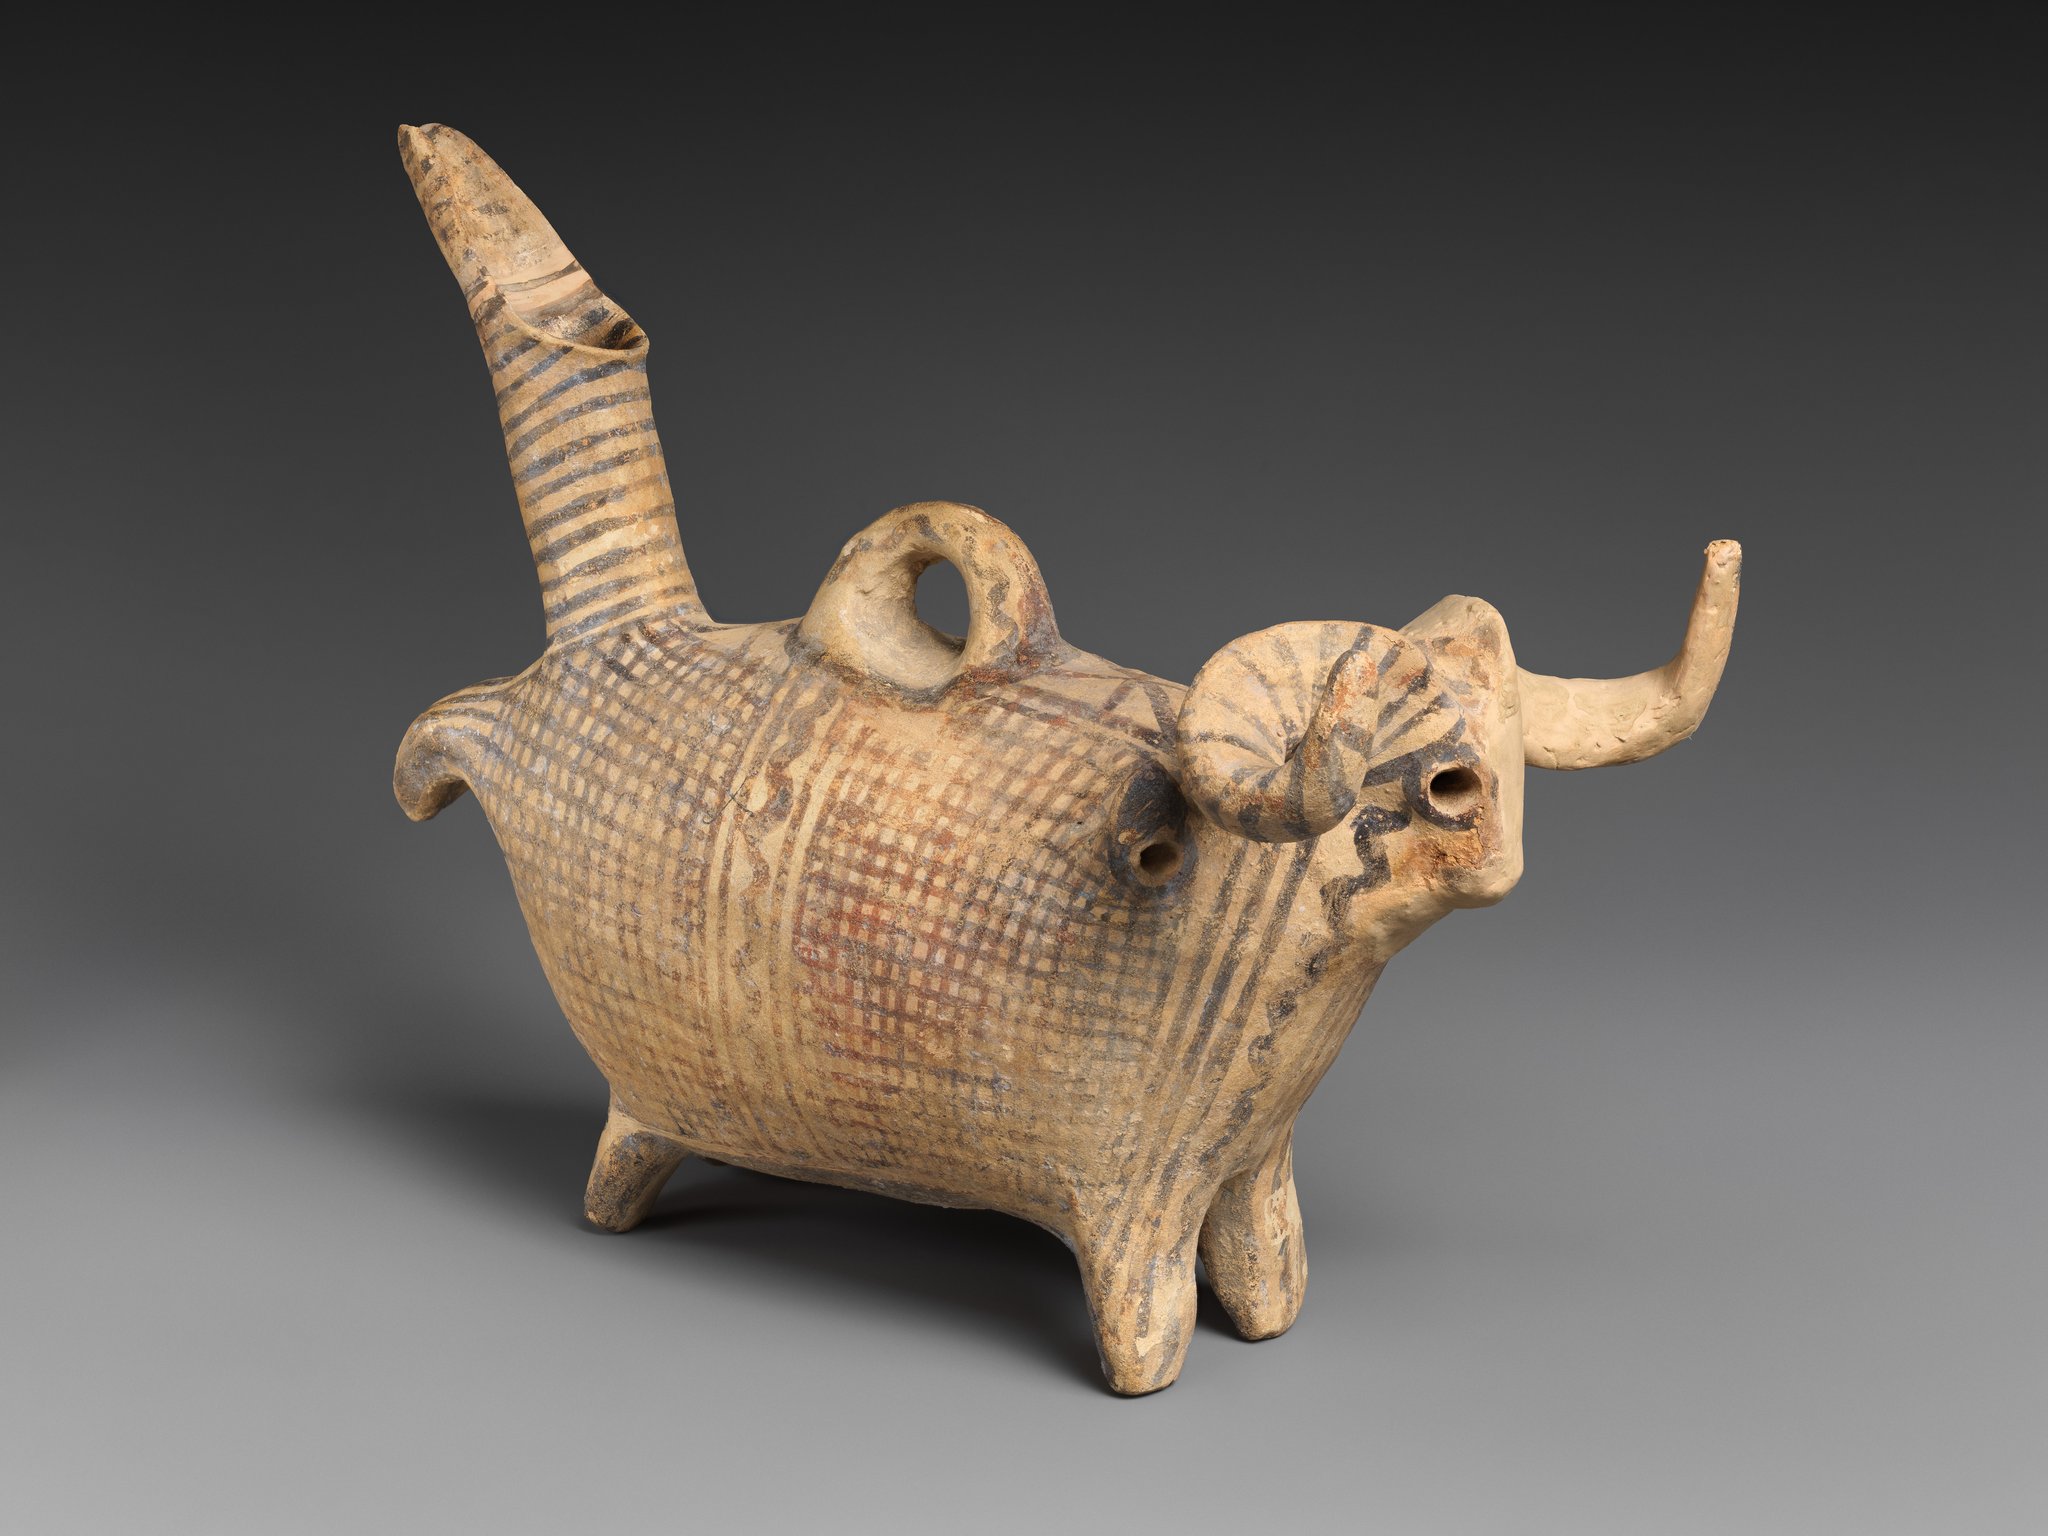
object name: askos in the form of an animal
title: Terracotta zoomorphic askos (vessel) with a ram's head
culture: cypriot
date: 1725-1600 BCE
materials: terracotta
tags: rams